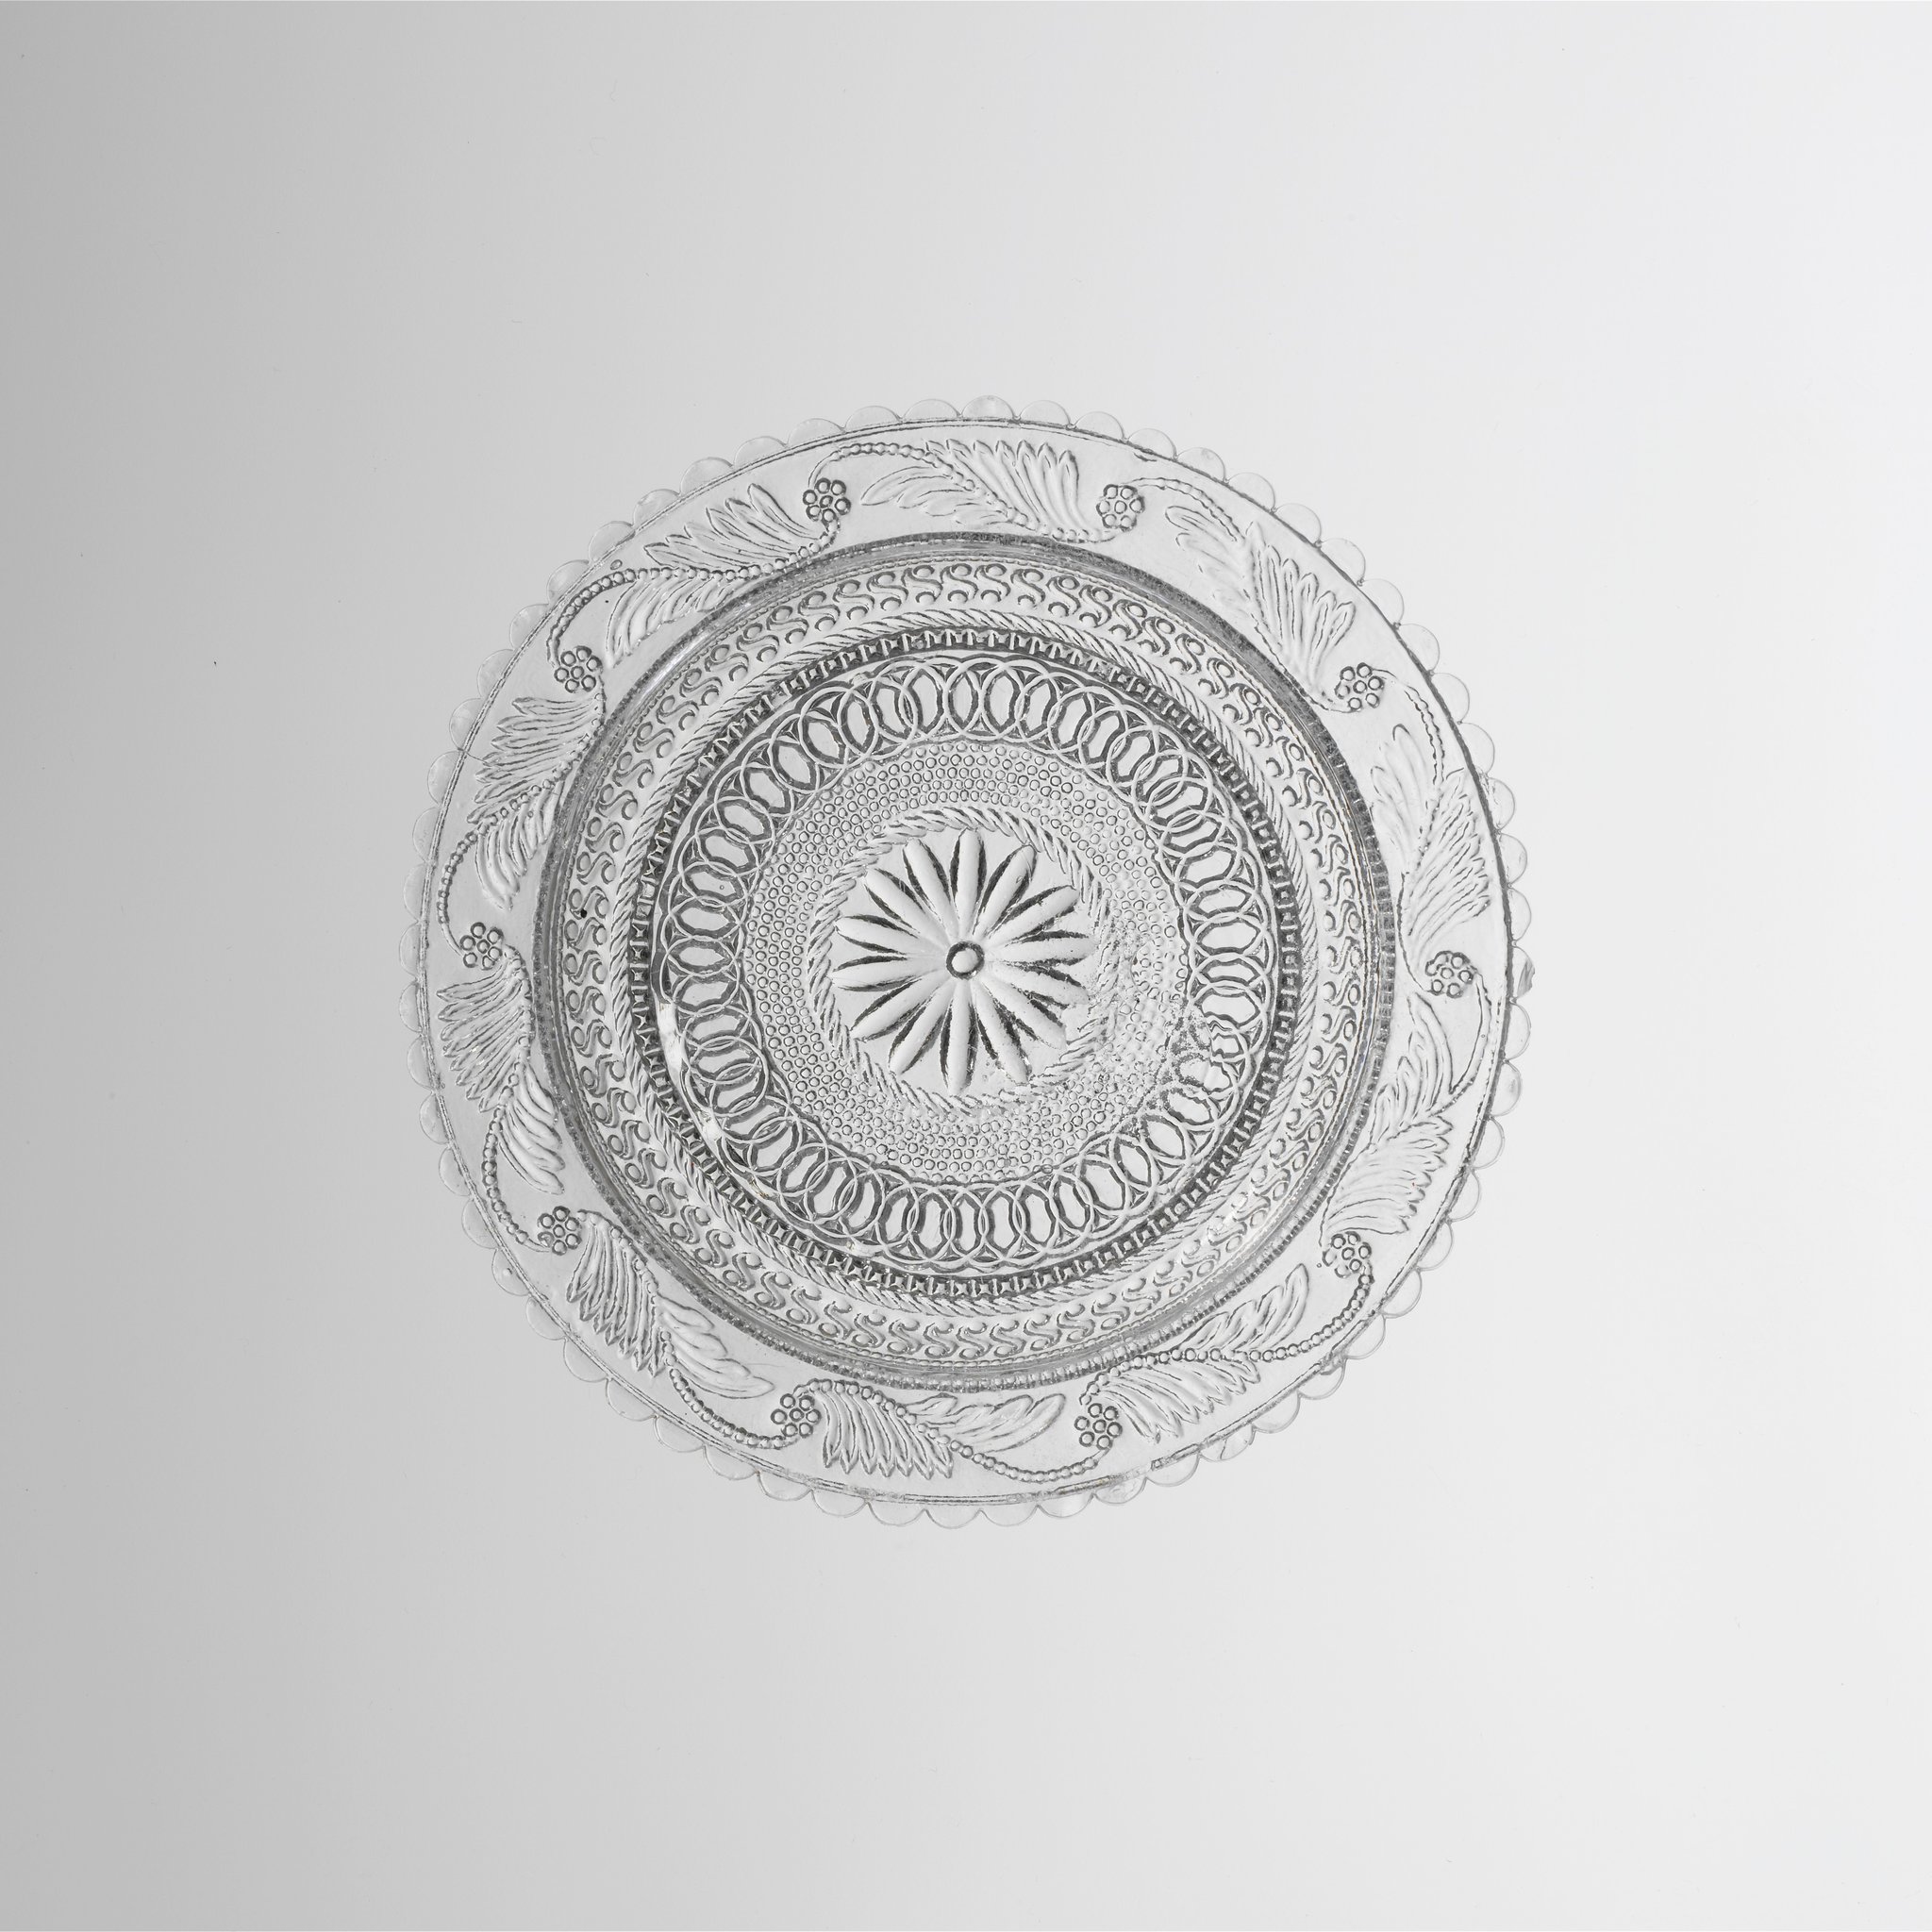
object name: cup plate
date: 1825-1860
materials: glass